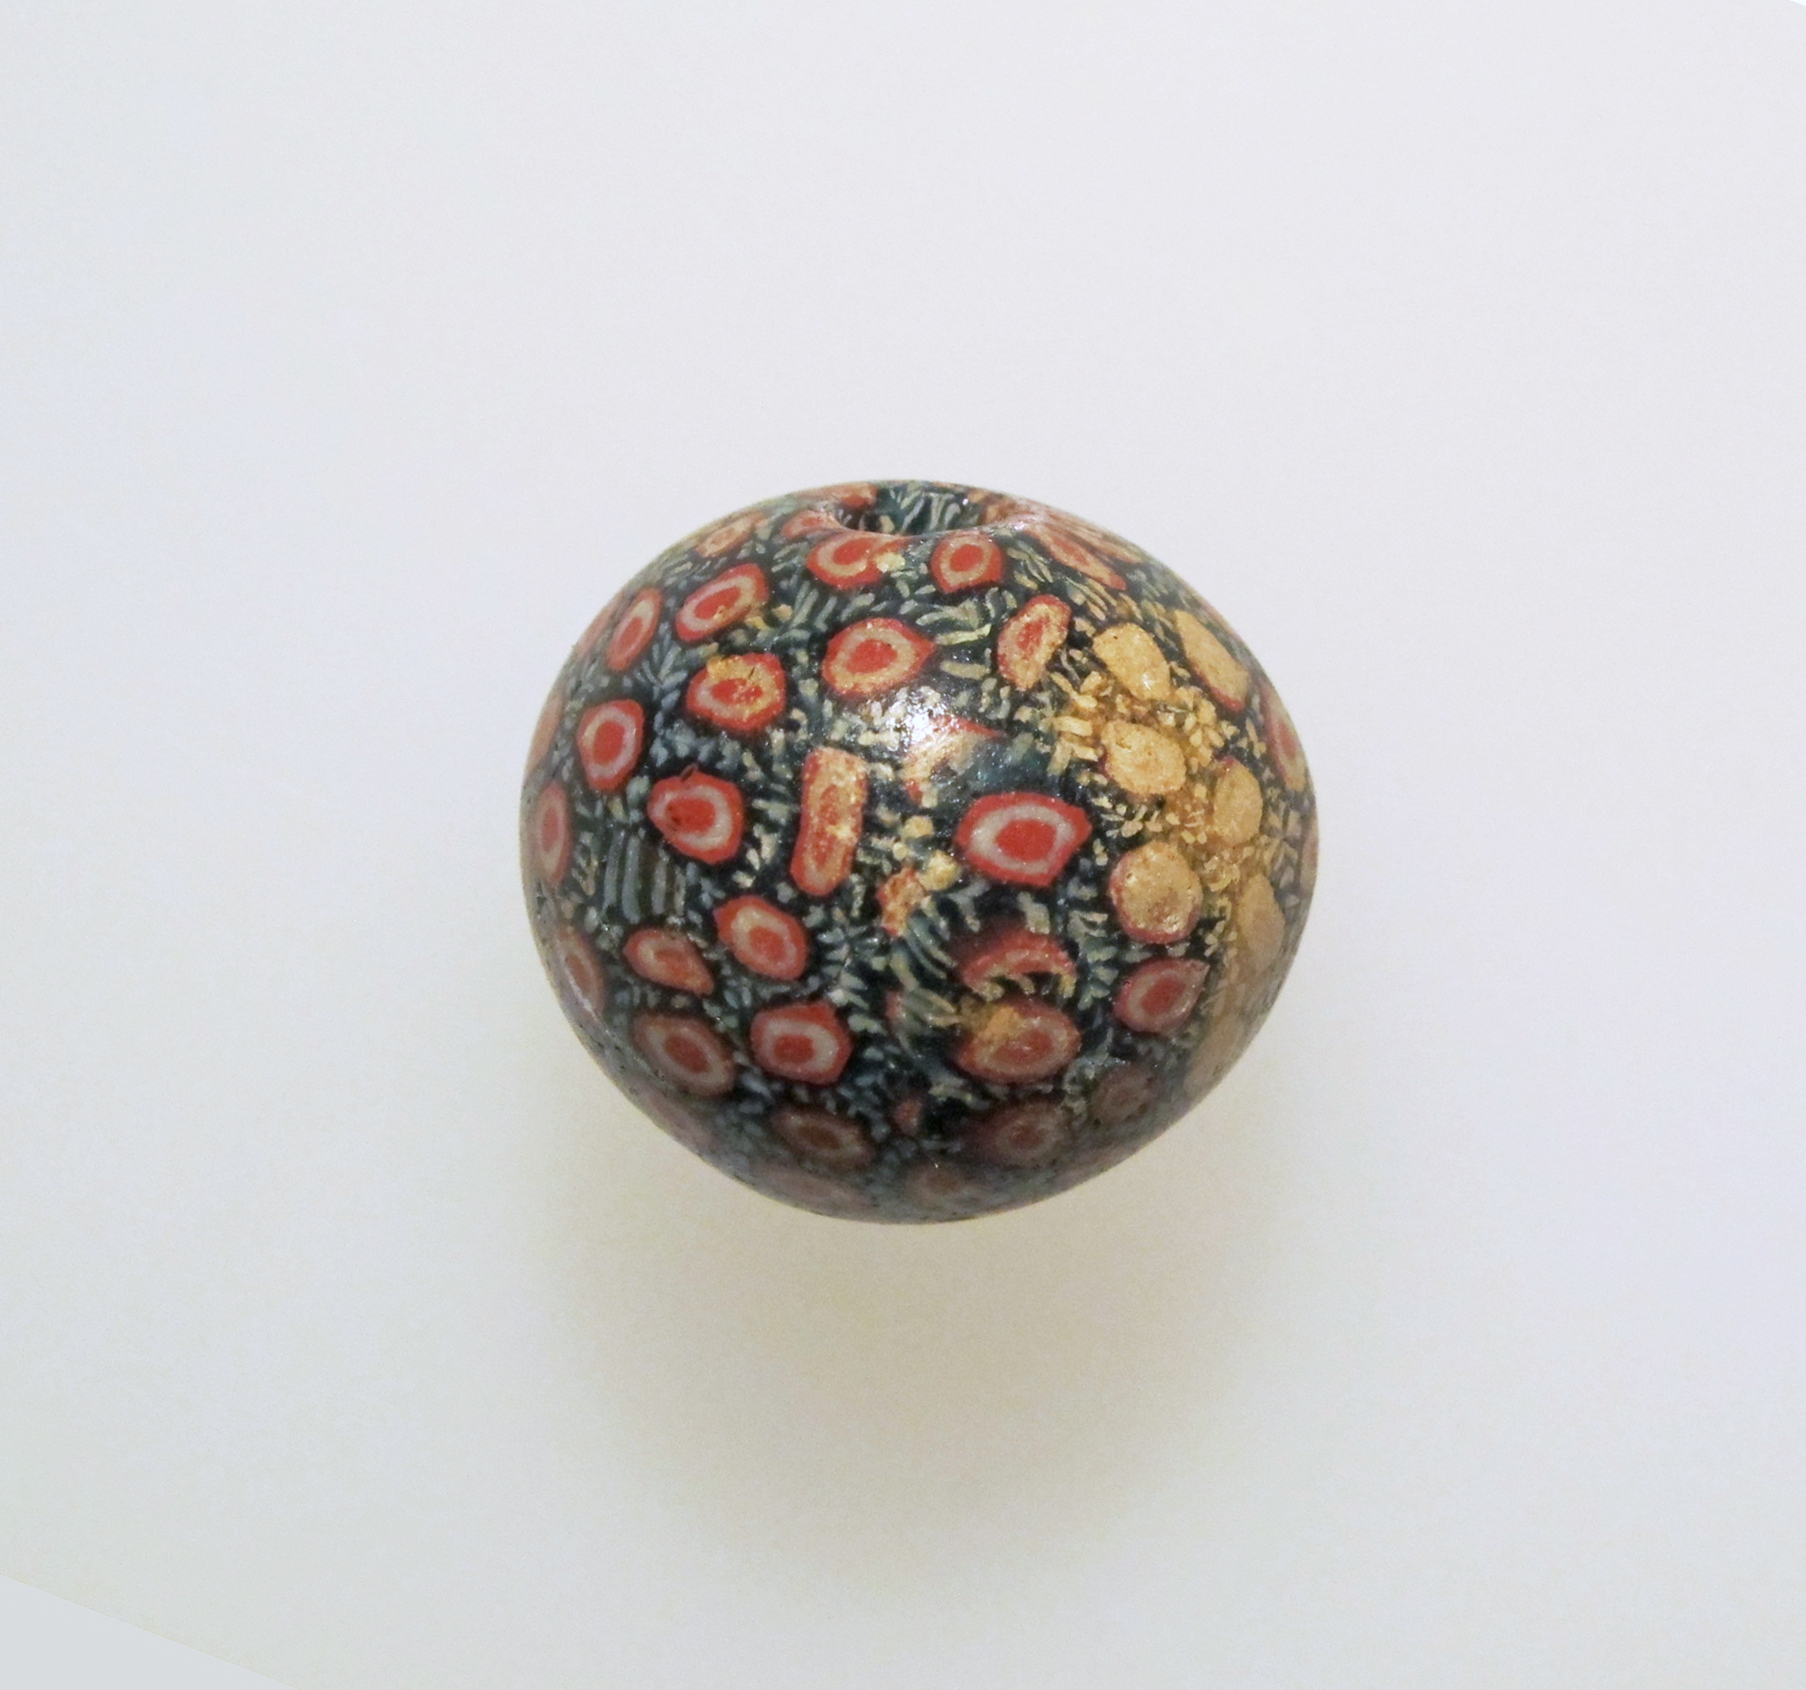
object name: millefiori bead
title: Glass mosaic bead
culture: roman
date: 1-100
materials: glass